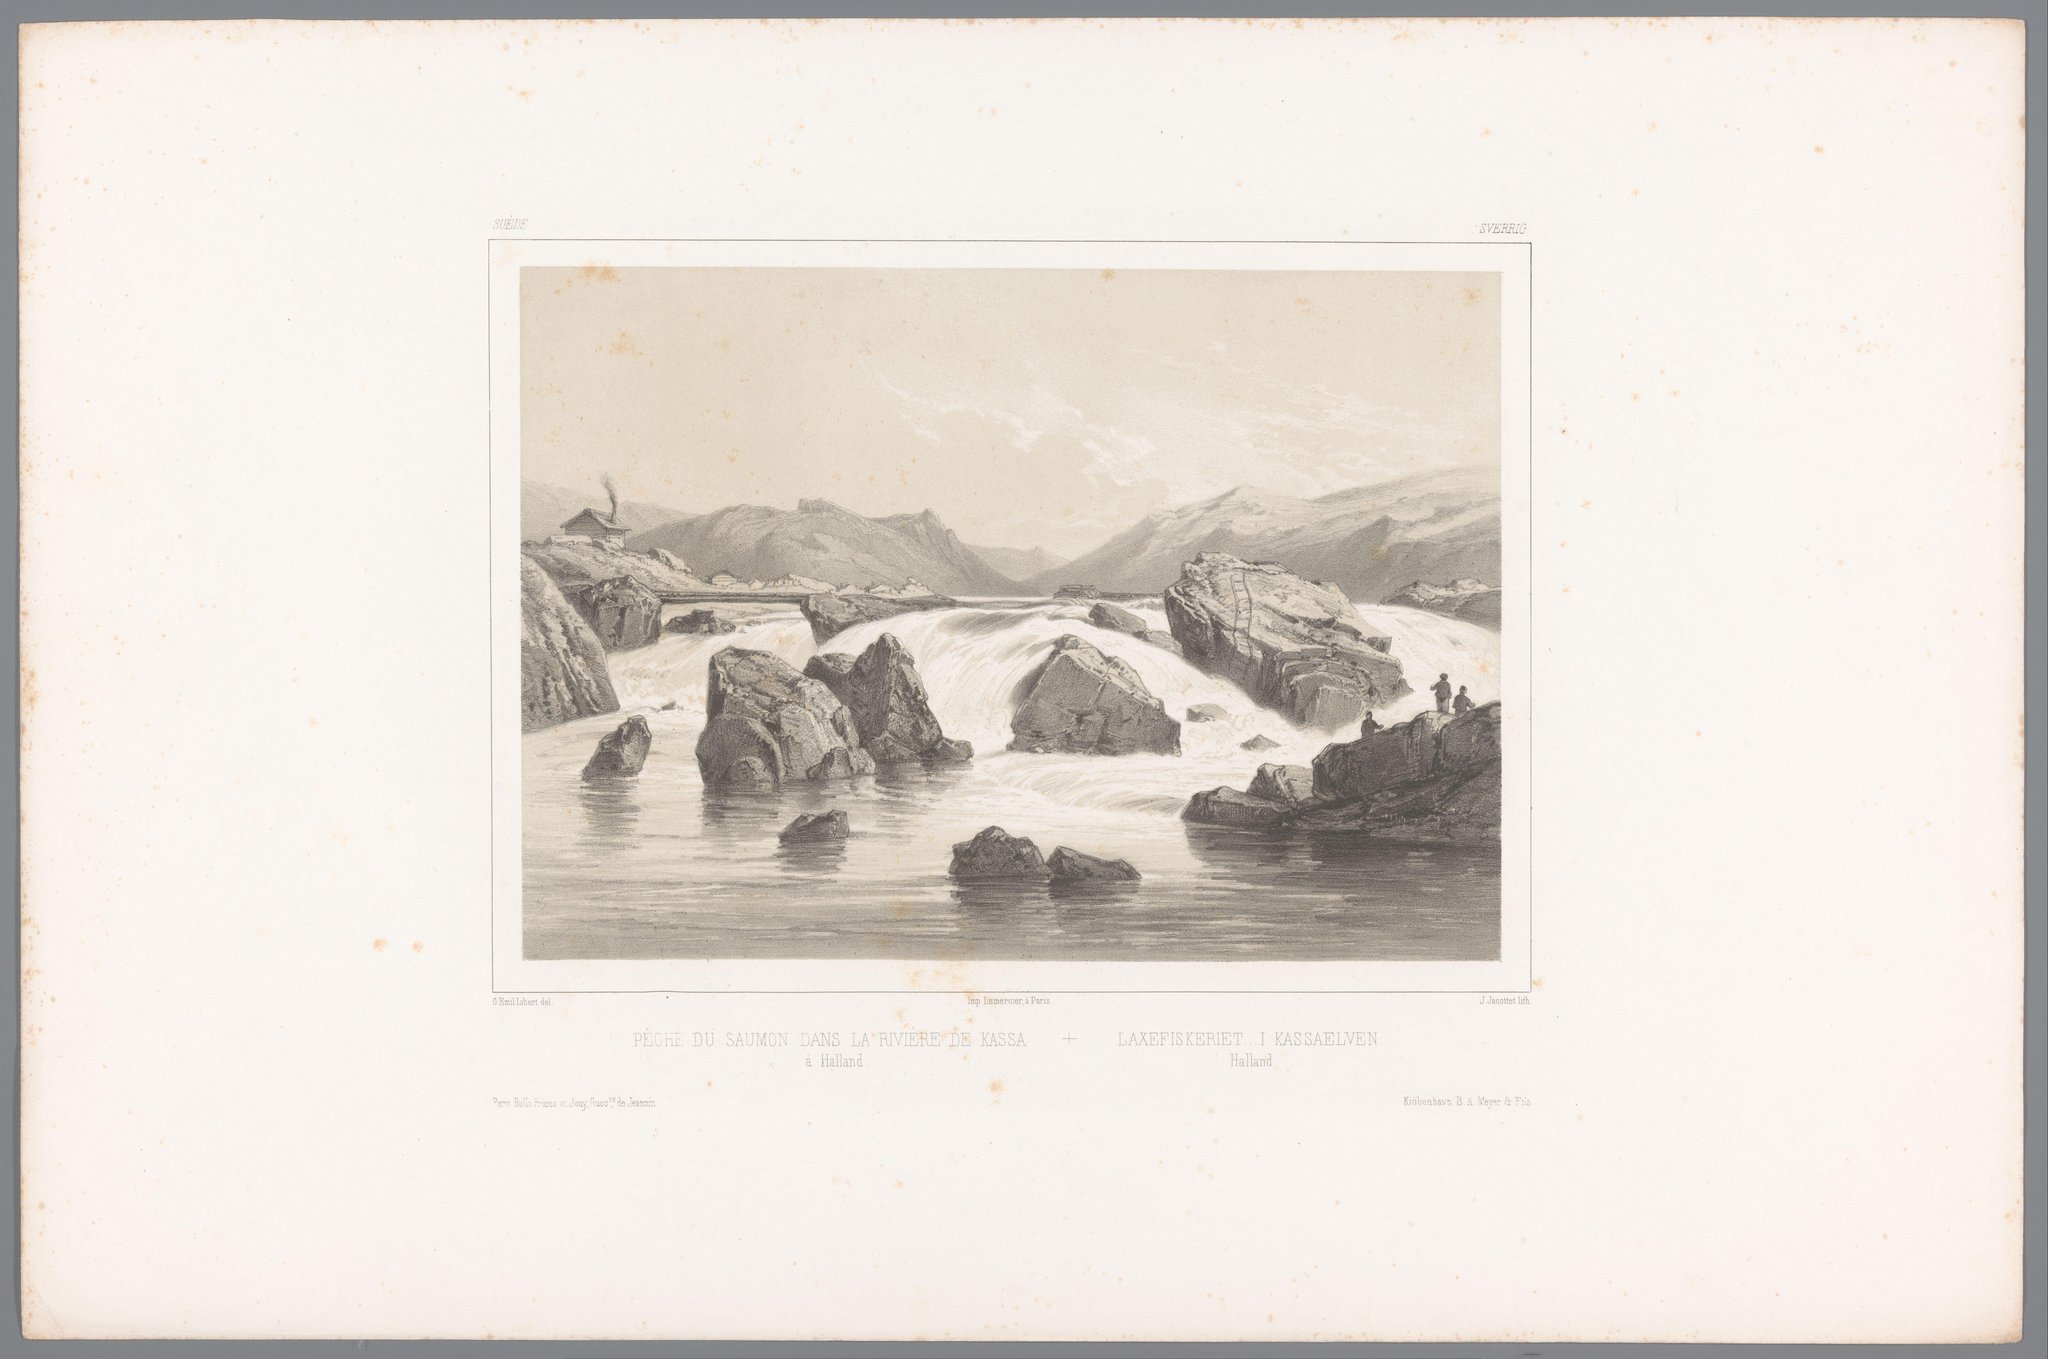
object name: print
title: Gezichten in Scandinavië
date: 1851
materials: paper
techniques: tone lithography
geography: copenhagen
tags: river (+ landscape with figures, staffage), rocks (+ landscape with figures, staffage)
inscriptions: collector's mark: Lugt 2228a